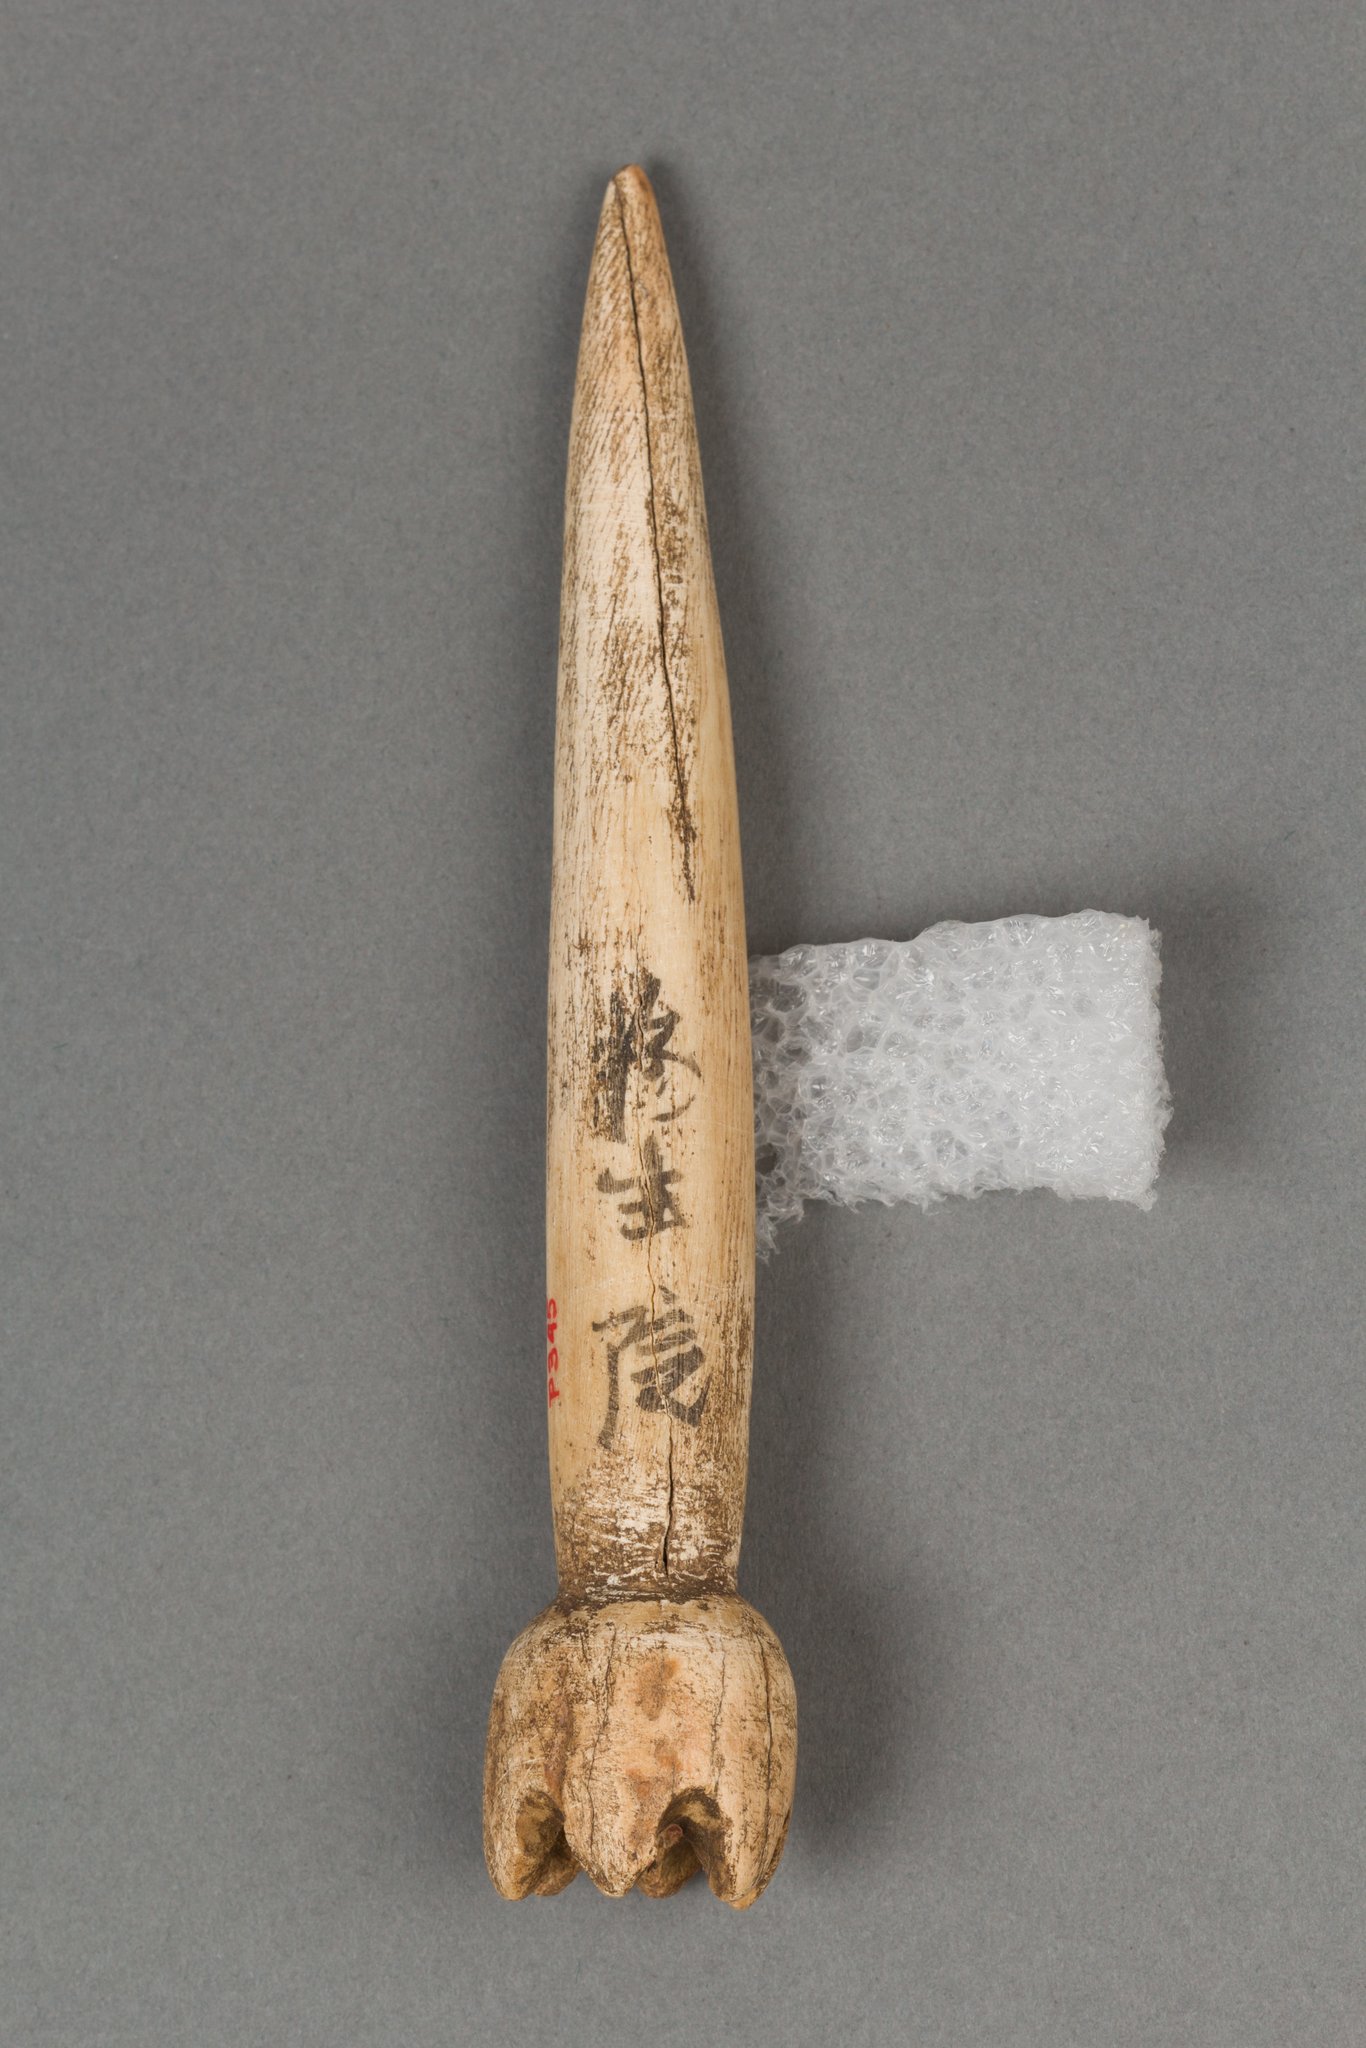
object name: body ornament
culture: japanese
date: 1000-300 BCE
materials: bone